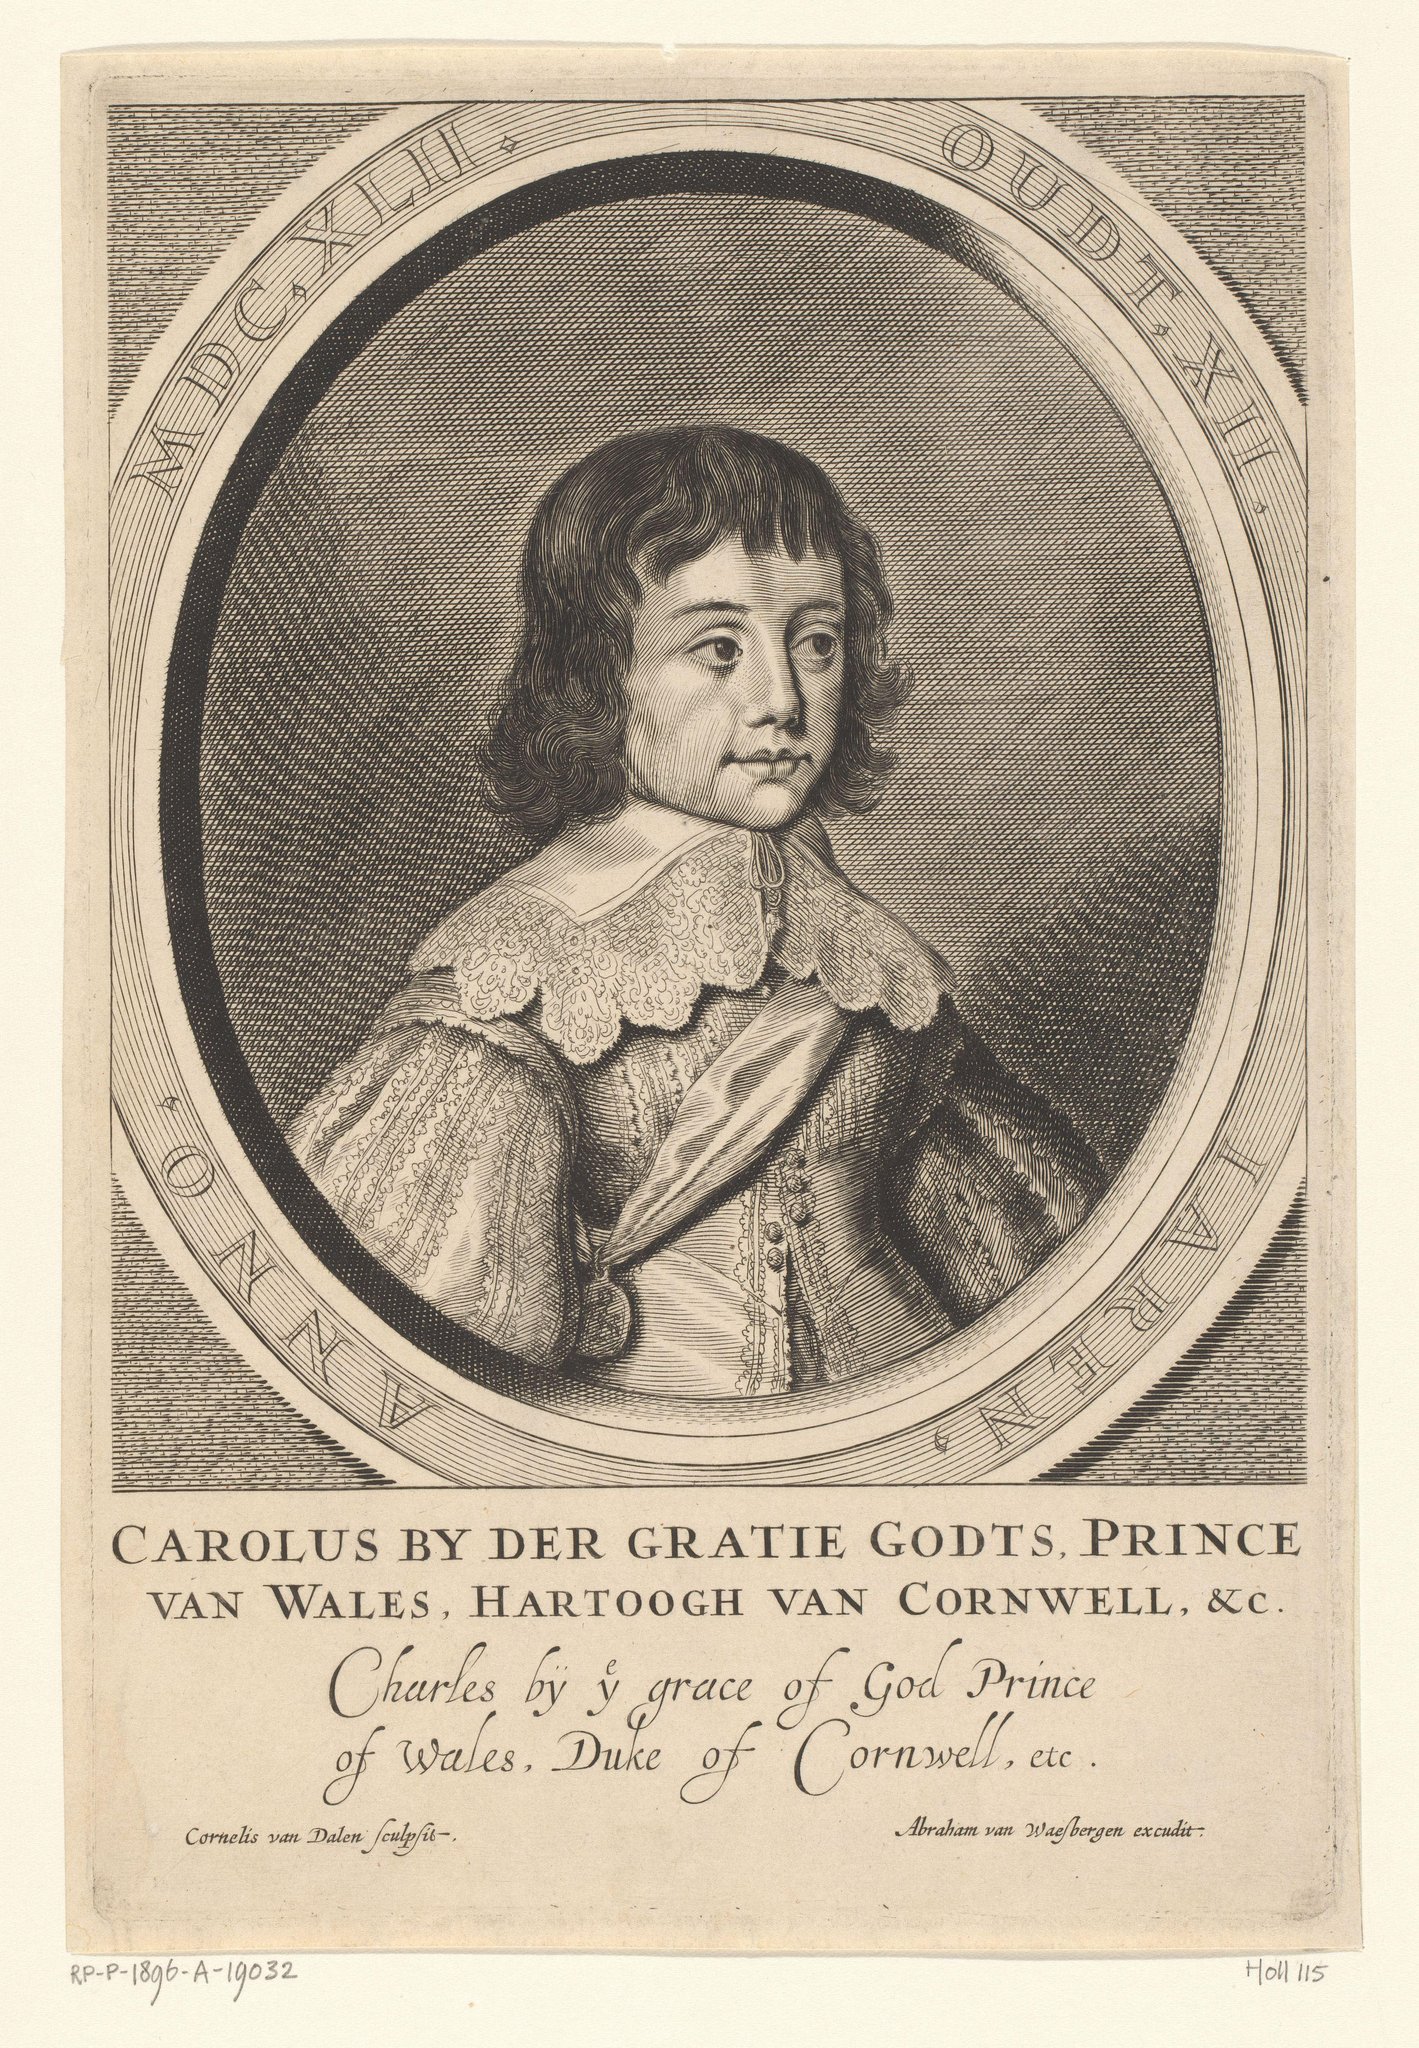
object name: print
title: Portret van Karel, prins van Wales op 12-jarige leeftijd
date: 1642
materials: paper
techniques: engraving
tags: london, karel ii (koning van engeland)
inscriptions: collector's mark: Lugt 2228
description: Portret van Karel, prins van Wales op 12-jarige leeftijd.